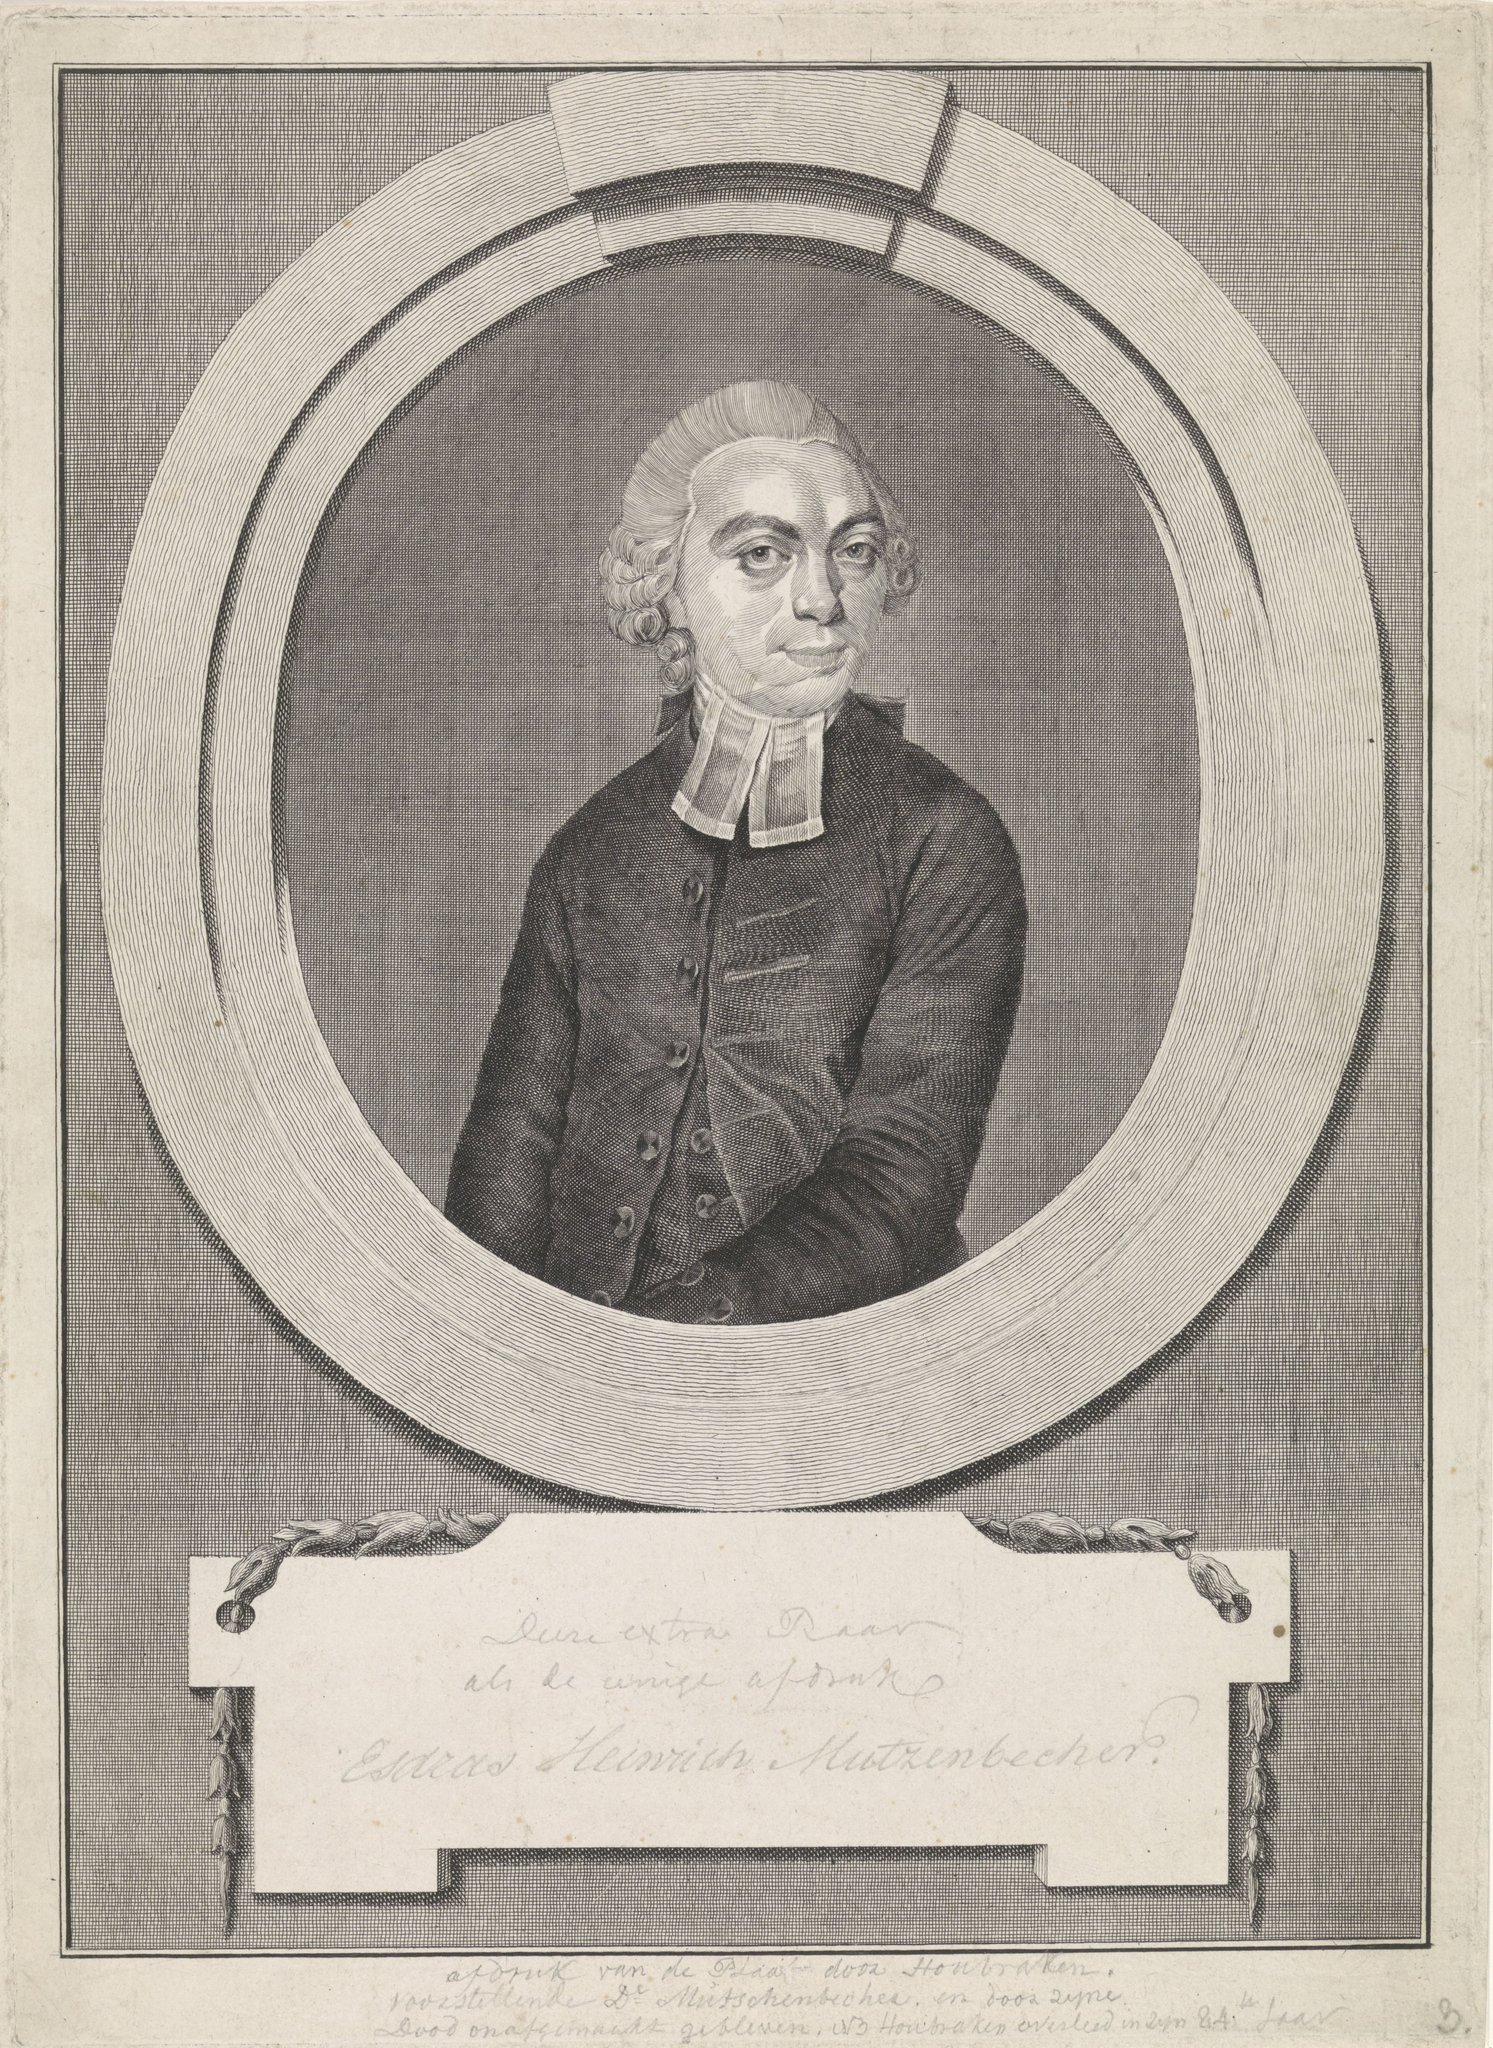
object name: print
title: Portret van Esdras Heinrich Mützenbecher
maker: jacob houbraken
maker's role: draughtsman, print maker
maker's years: 1698-1780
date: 1780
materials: paper, pencil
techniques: engraving, etching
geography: amsterdam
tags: esdras heinrich mützenbecher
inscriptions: inscription: Afdruk van de Plaat door Houbraken/ voorstellende De. Mutschenbecher en door zijne/ dood onafgemaakt gebeleven/ Houbraken overleed in zijn 84e jaar, collector's mark: Lugt 2228, inscription: ‘Deeze extra Raar/ als de eenige afdruk/ Esdras Heinrich Mutzenbecher’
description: Portret ten halven lijve van Esdras Heinrich Mützenbecher, onvoltooid, in een ovaal. Onder het portret een cartouche waarop drie handgeschreven regels.